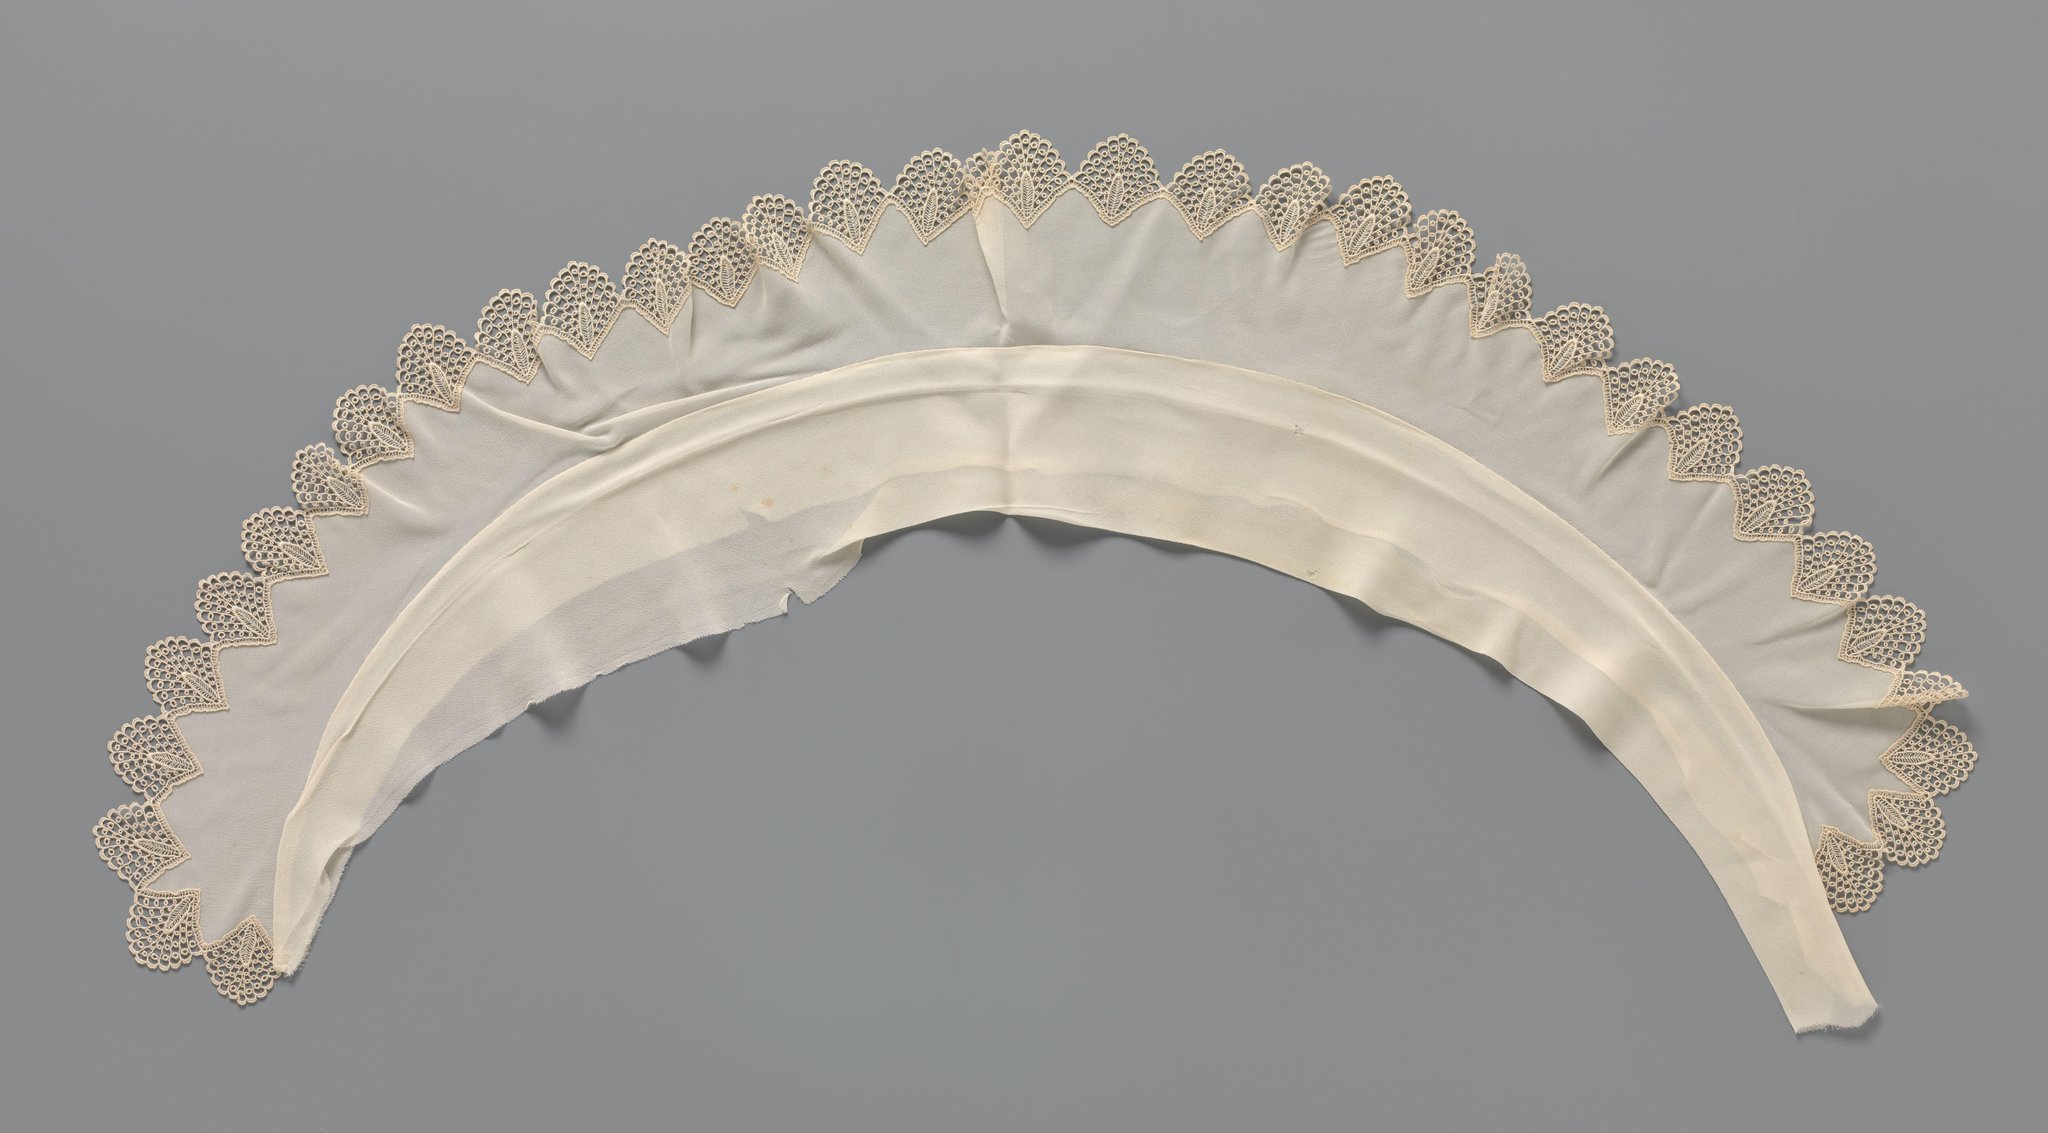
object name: sjaalkraag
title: Sjaalkraag van beige crêpe georgette met schulpenrand van machinale kant in de vorm van pauwenstaarten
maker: Anonymous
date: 1933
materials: textile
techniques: lace, weave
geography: netherlands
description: Sjaalkraag van beige gekleurd crêpe georgette met een schulpenrand van machinale kant: etskant. De schulpen hebben de vorm van pauwenstaarten. De kraag heeft een liggend benedendeel en een omslag langs de hals. De rechter overslag wordt ver door het linker bedekt.